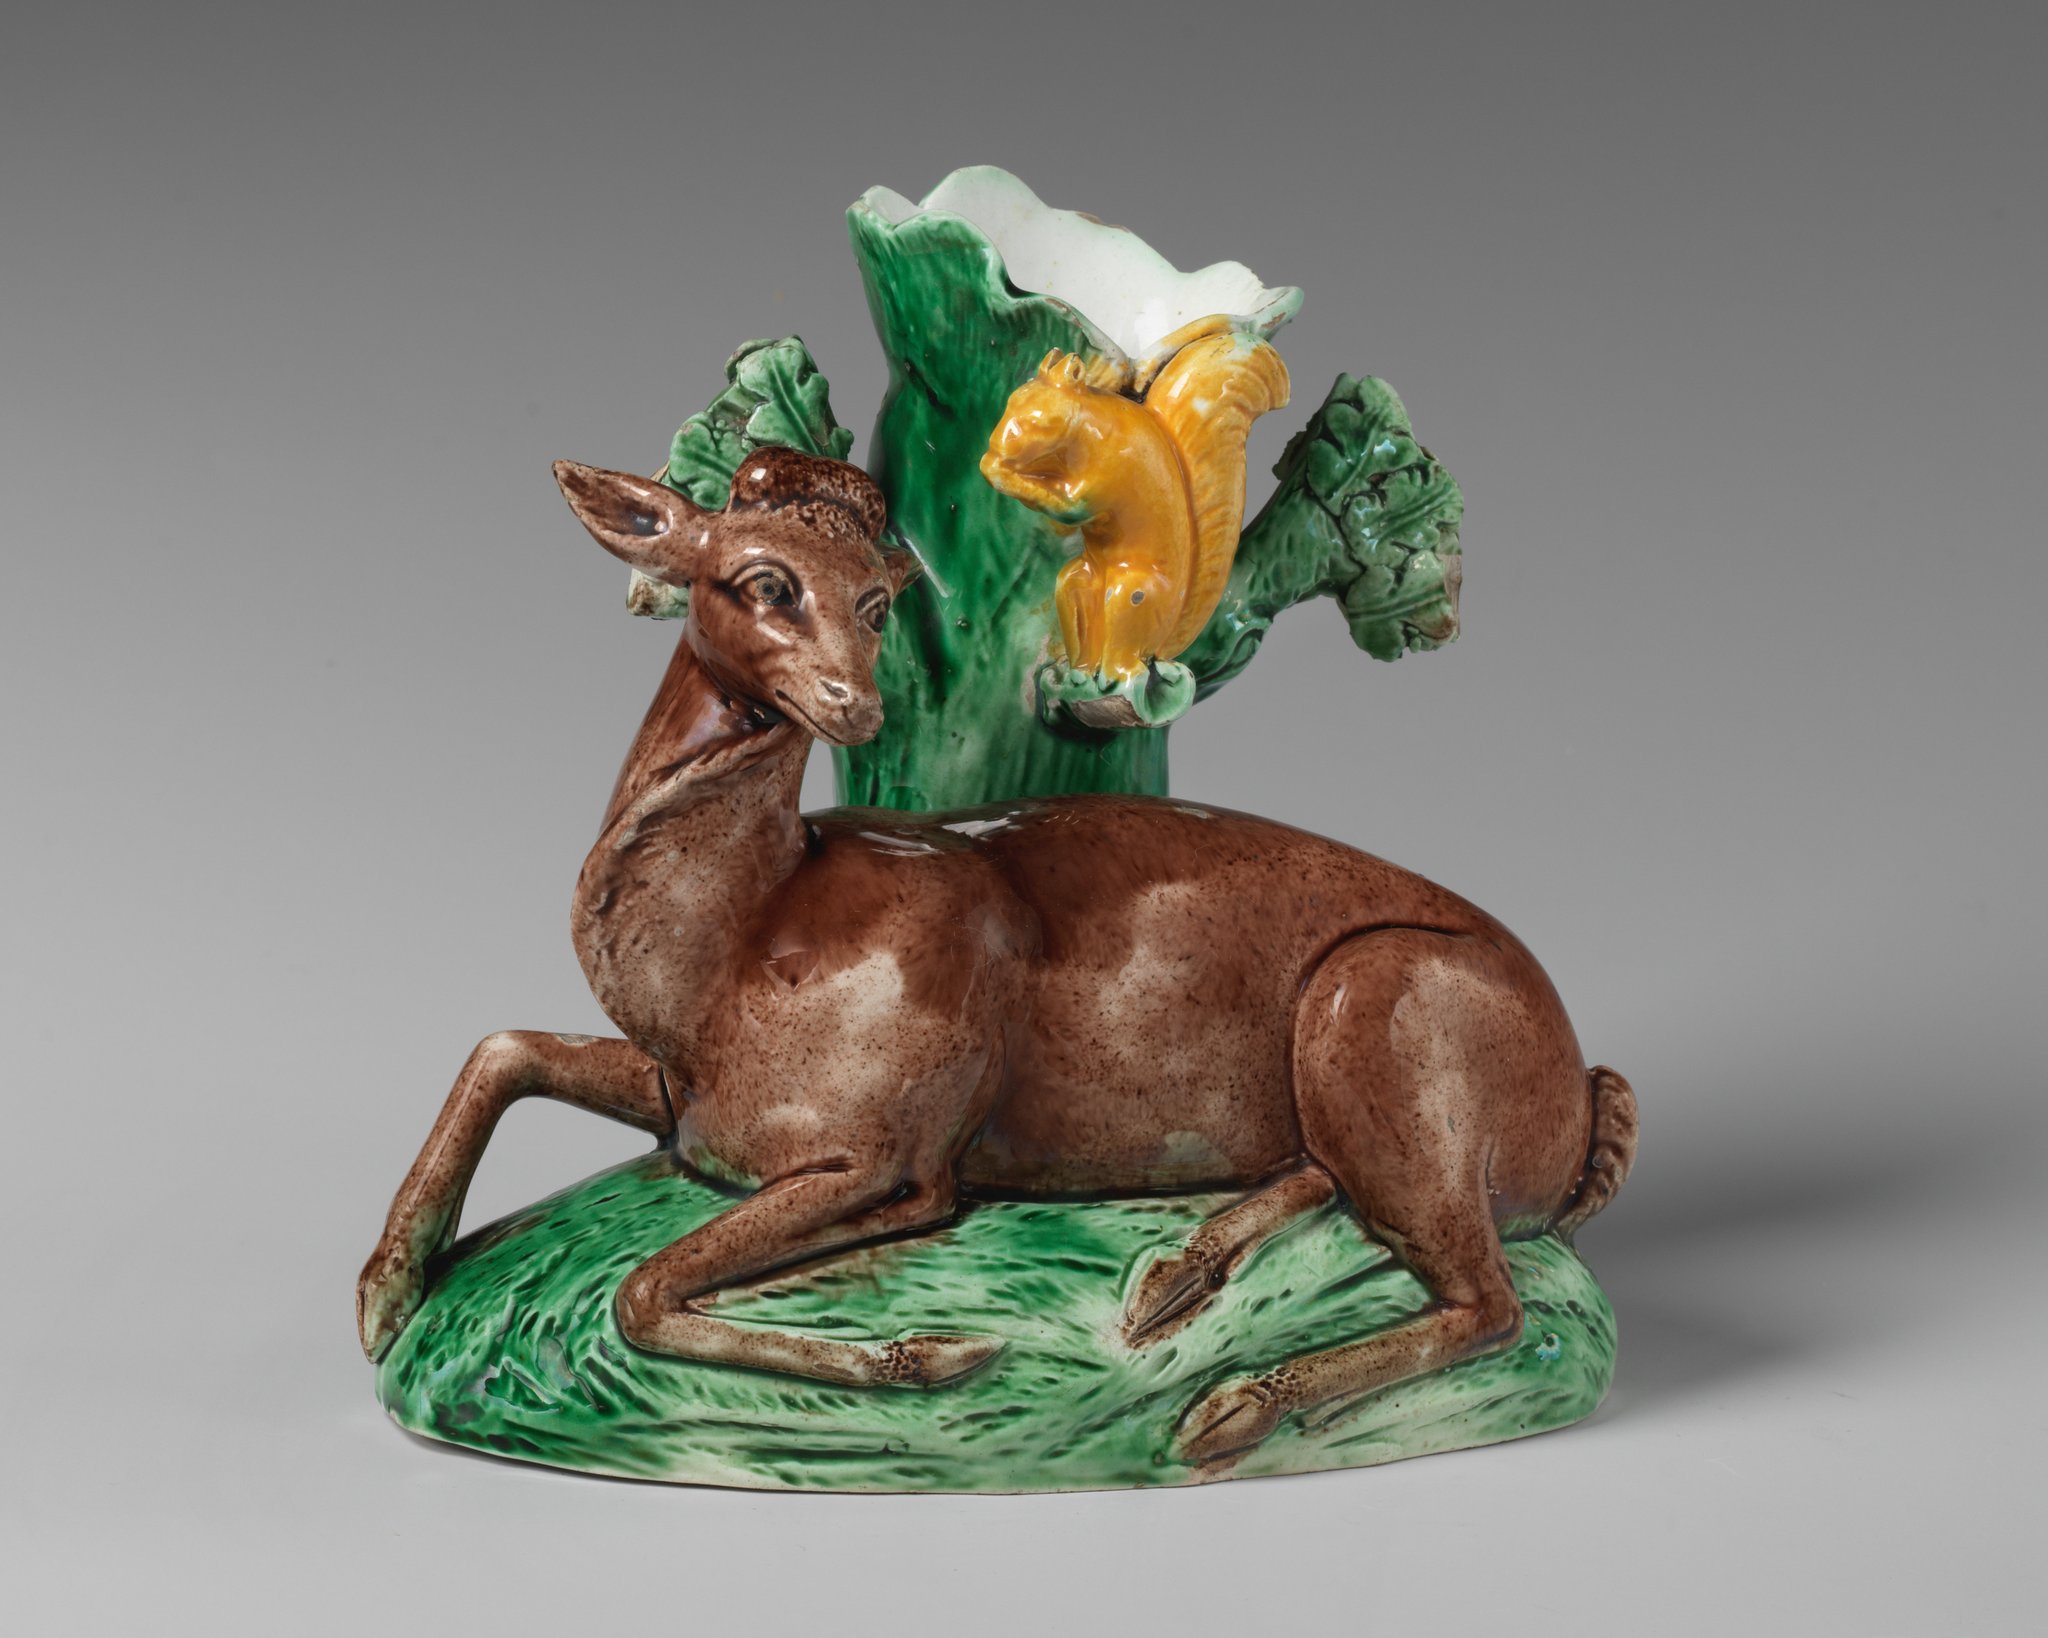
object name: flower vase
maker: ralph wood the elder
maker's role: maker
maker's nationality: british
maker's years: 1715-1772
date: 1780-1790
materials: earthenware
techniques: glazing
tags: deer,squirrels